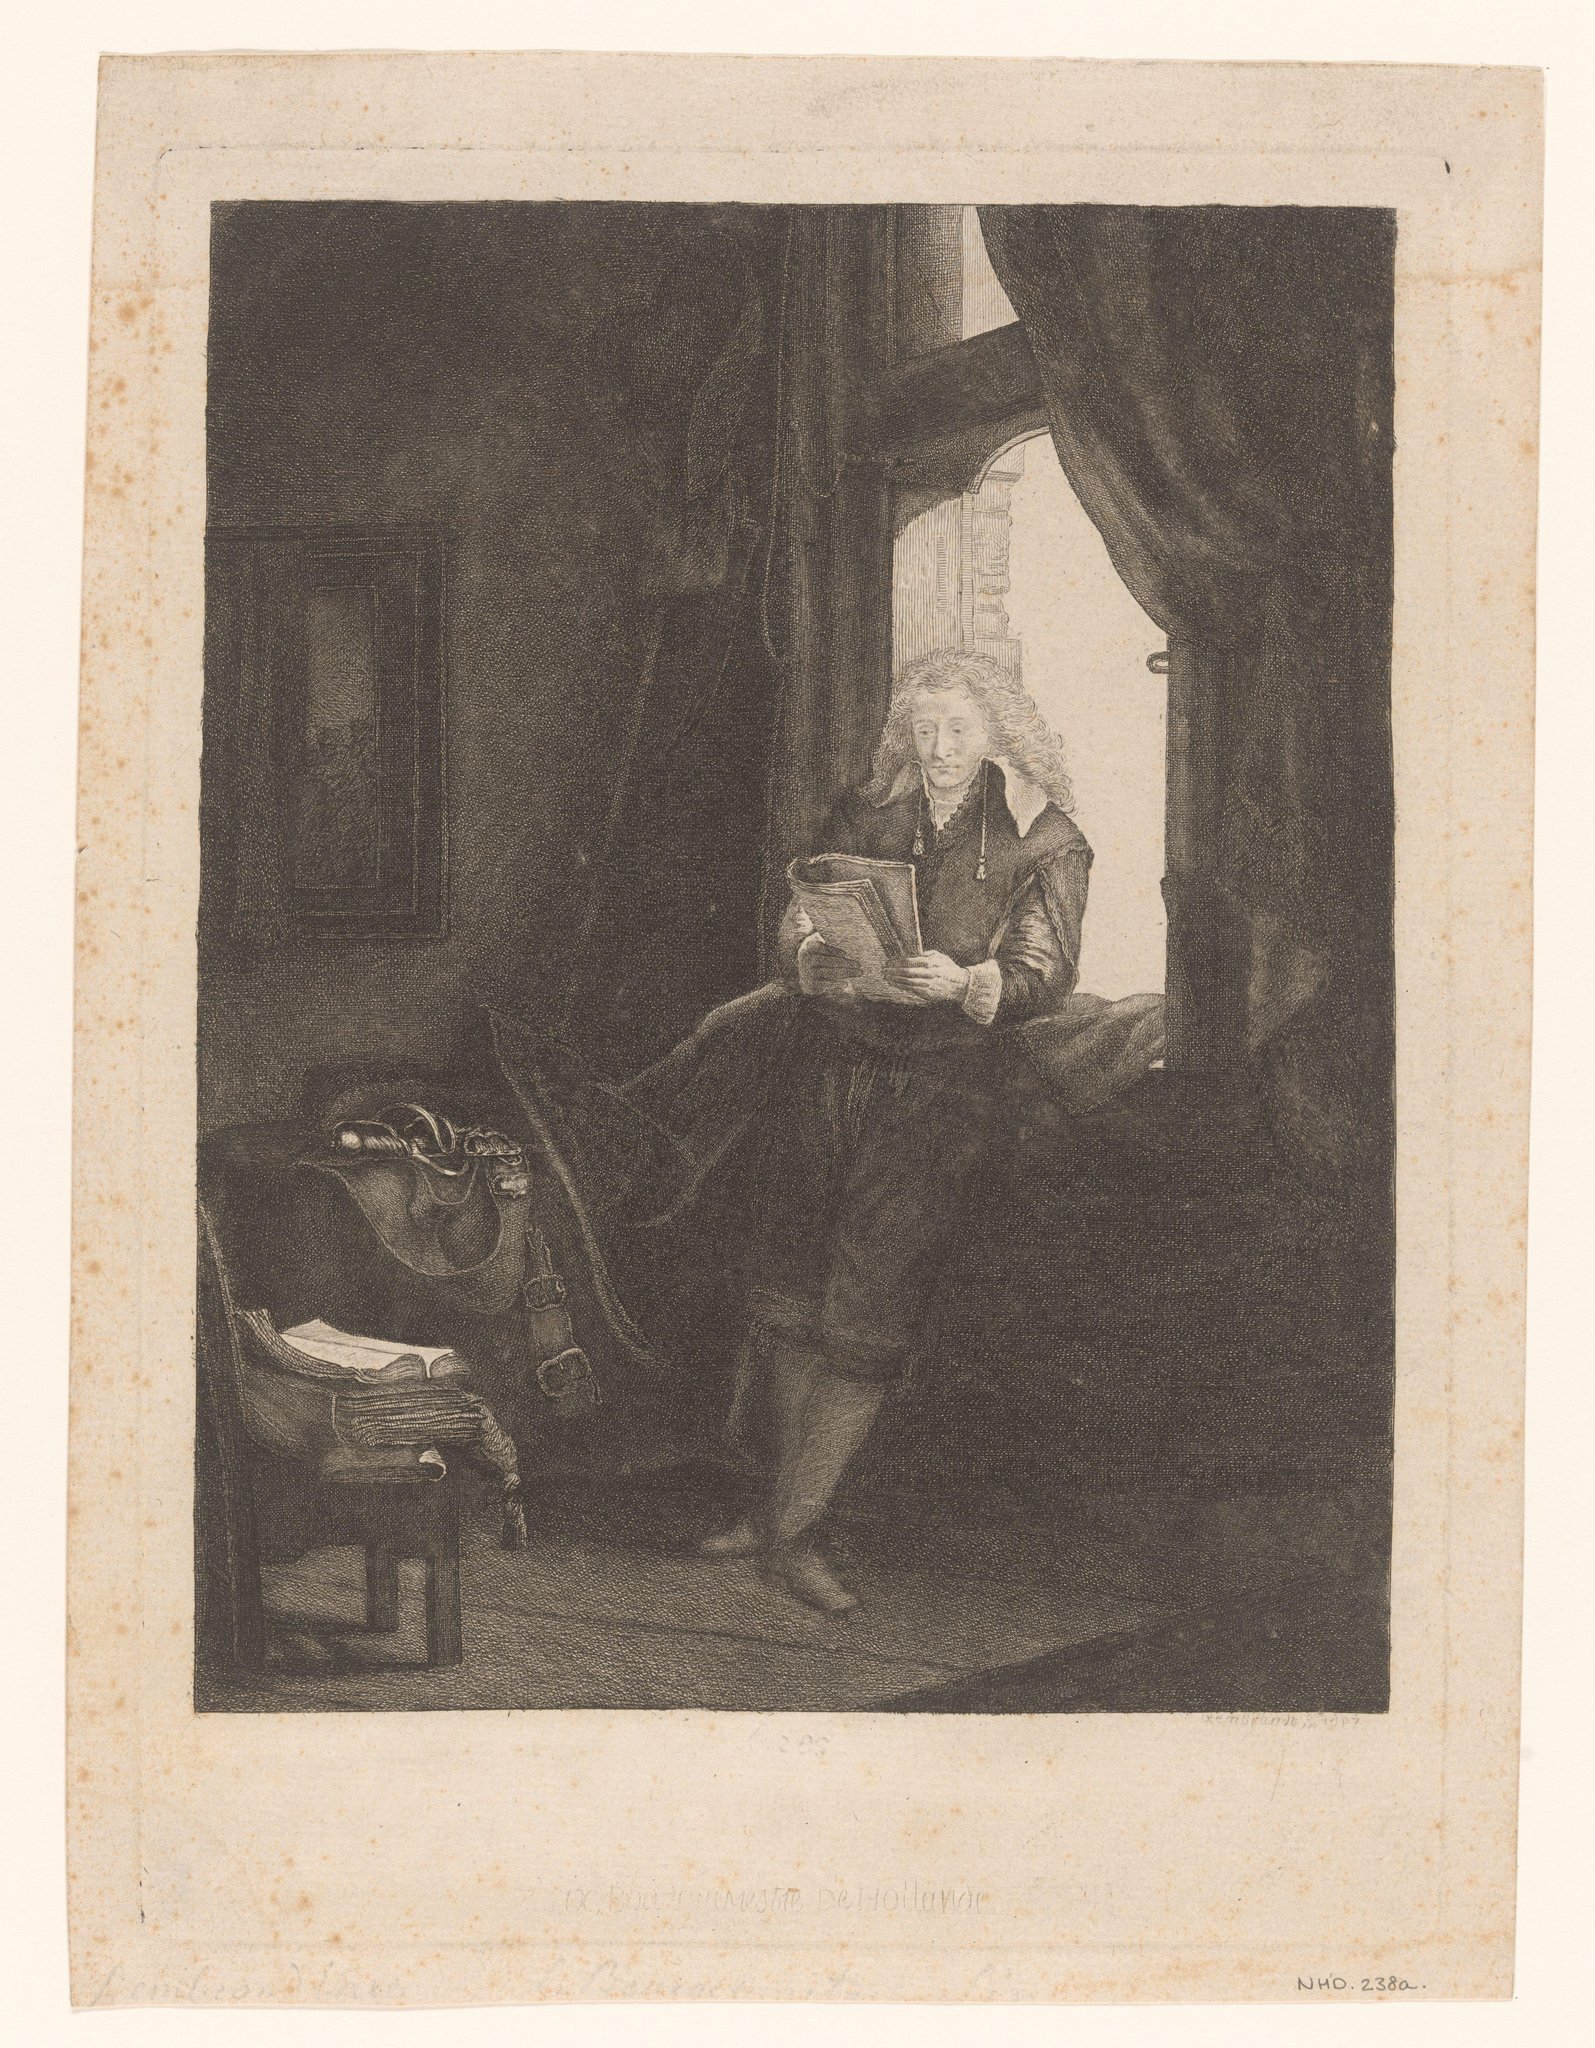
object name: print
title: Jan Six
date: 1733-1797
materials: paper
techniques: etching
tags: mayor, jan six (1618-1700), historical persons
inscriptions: collector's mark: Lugt 2760, collector's mark: Lugt 4071, collector's mark: ‘herladisch wapen’, collector's mark: Lugt 2228